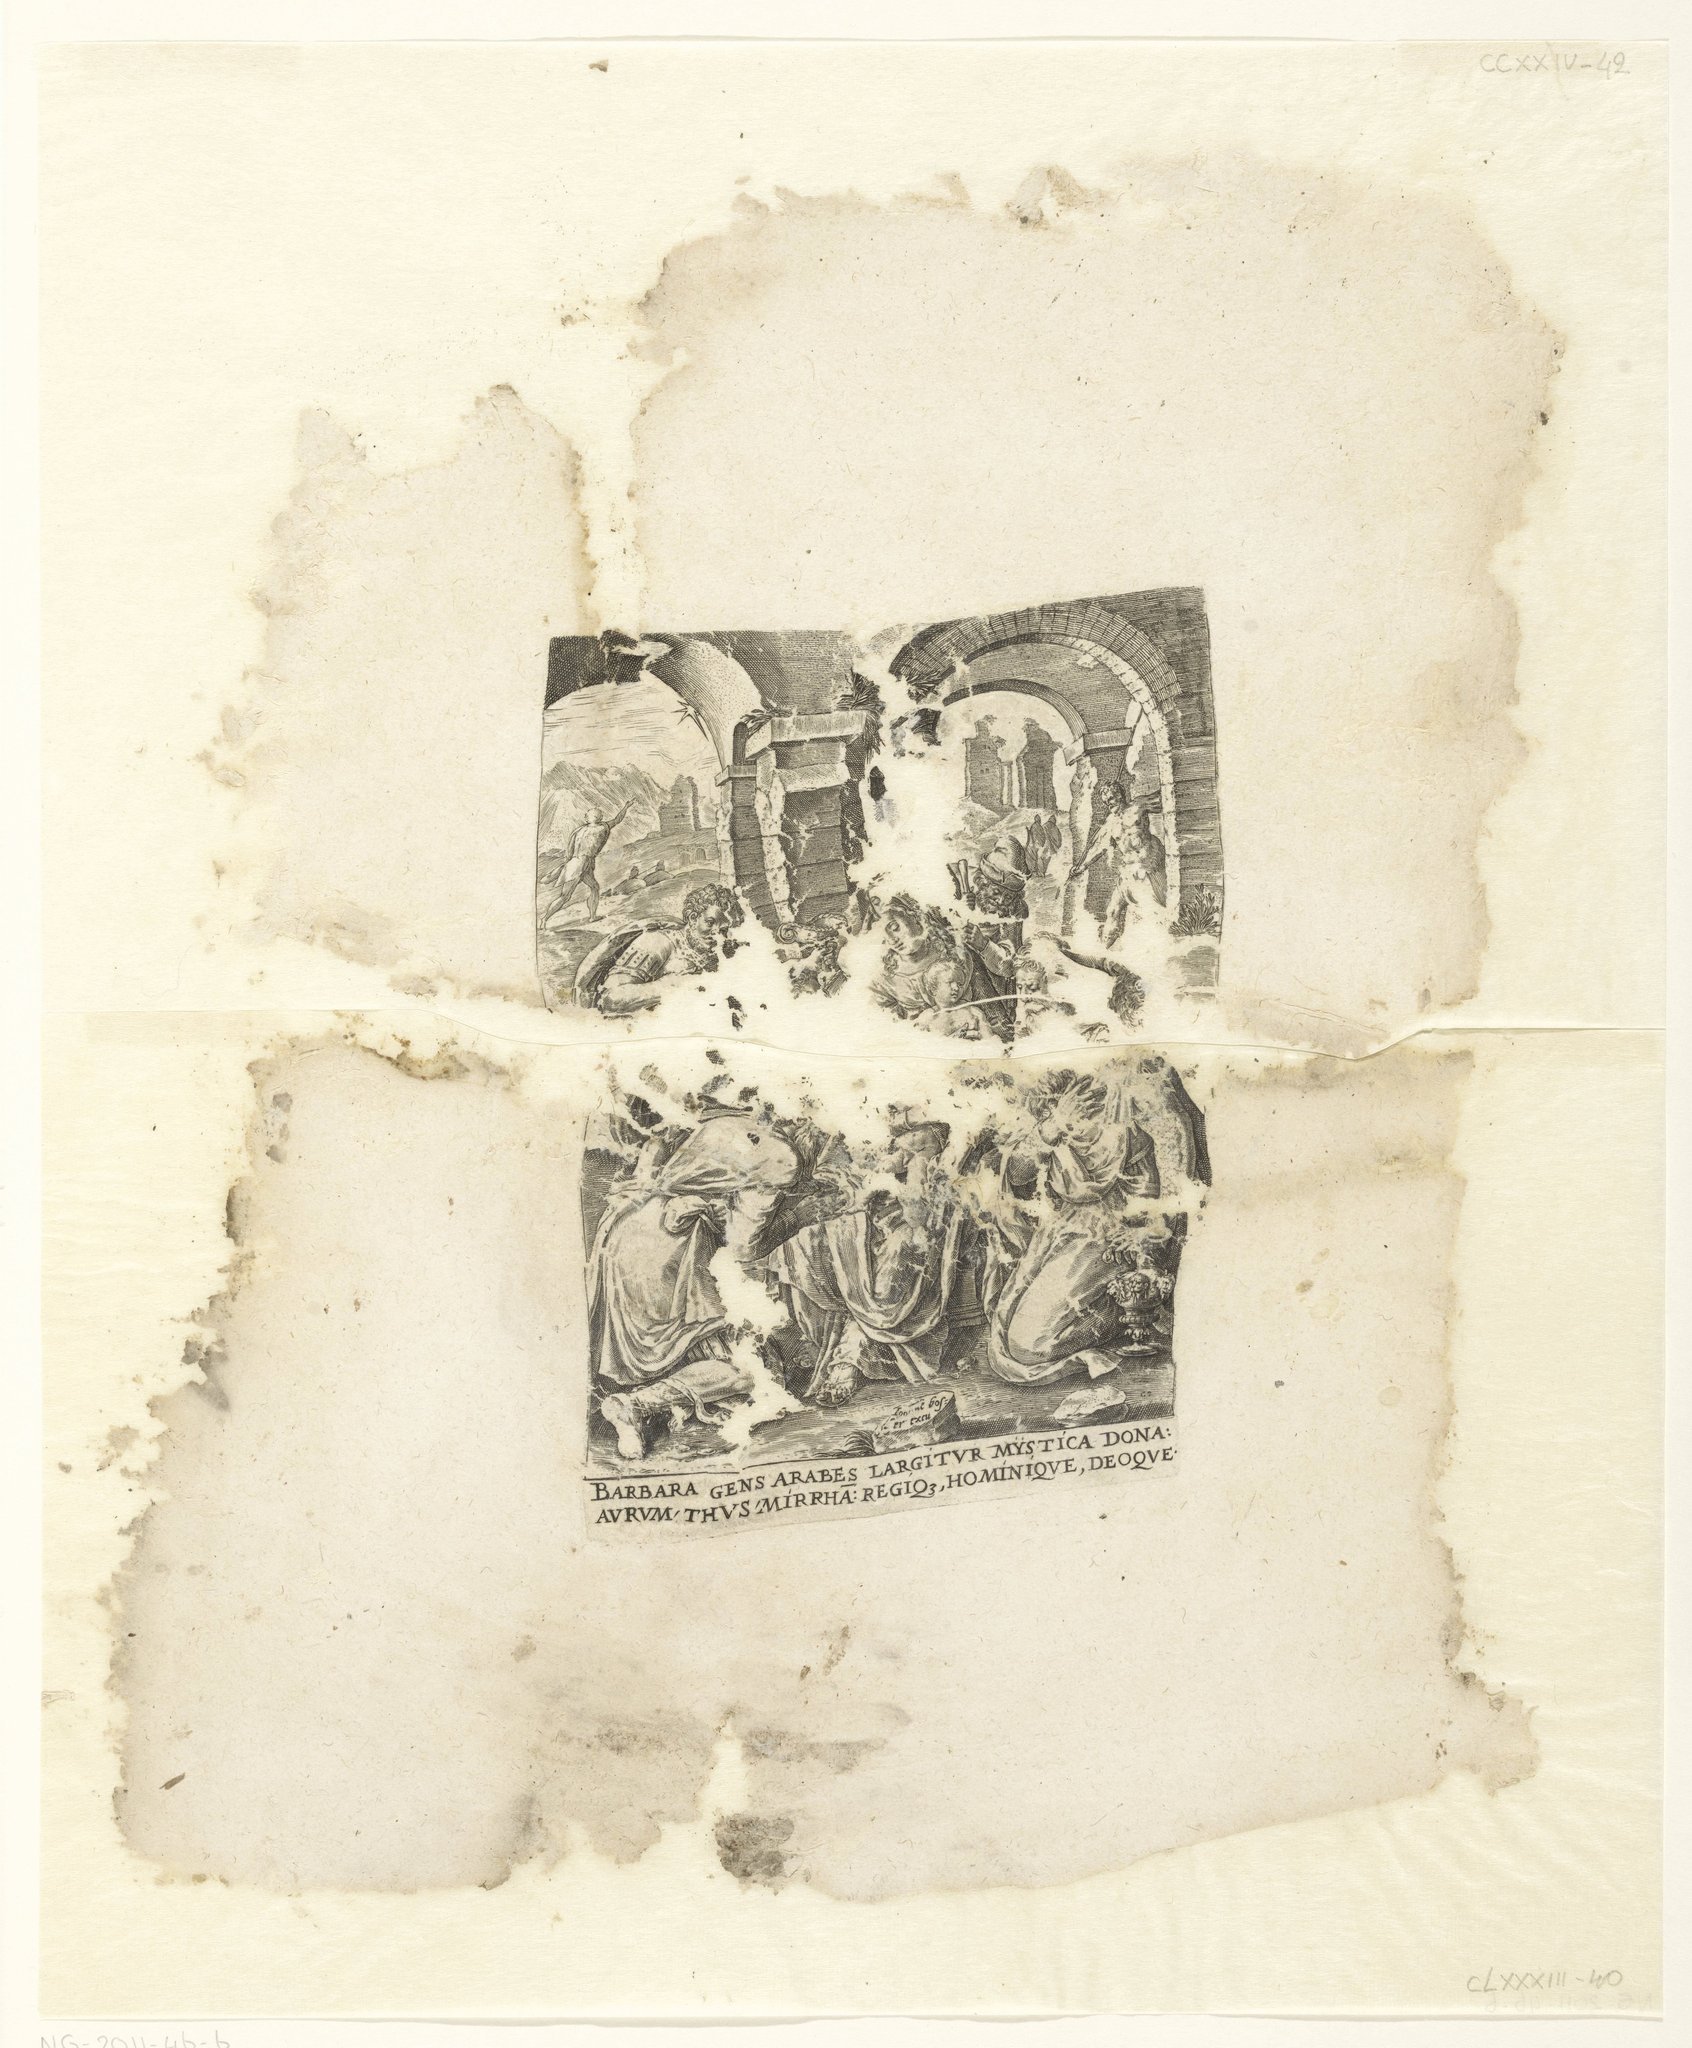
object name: print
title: Aanbidding door de koningen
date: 1570-1596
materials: paper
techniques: engraving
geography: southern netherlands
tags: adoration of the kings: the wise men present their gifts to the christ-child (gold, frankincense and myrrh)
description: Deze tot dusver onbekende door Joos de Bosscher uitgegeven prent kan nog tot diens Antwerpse uitgaven behoren. De prenten in de Nova Zembla collectie zijn tijdens een expeditie van Willem Barendsz en Jacob van Heemskerk in 1596-1597 noodgedwongen in het winterkamp, het ‘Behouden Huis’, op het eiland achtergelaten. De prenten waren in één of meerdere stapels als handelswaar meegenomen vanuit Amsterdam. Bijna drie eeuwen later, in 1871, keerde de Noor Elling Carlsen terug naar Nova Zembla en vond daar de restanten van het ‘Behouden Huis, inclusief een groot deel van de inventaris. Een deel van de prenten, in de vorm van aaneengekoekte kluiten, werd toen ook teruggevonden. De papierkluiten waren soms op meerdere plekken gebroken. Tussen 1975-1979 zijn de prenten van elkaar gescheiden. Dit leverde in totaal ca. 1000 fragmenten van ca. 400 afdrukken van ca. 150 verschillende prenten op. Voor zover mogelijk zijn de fragmenten samengevoegd en zijn de prenten gereconstrueerd.